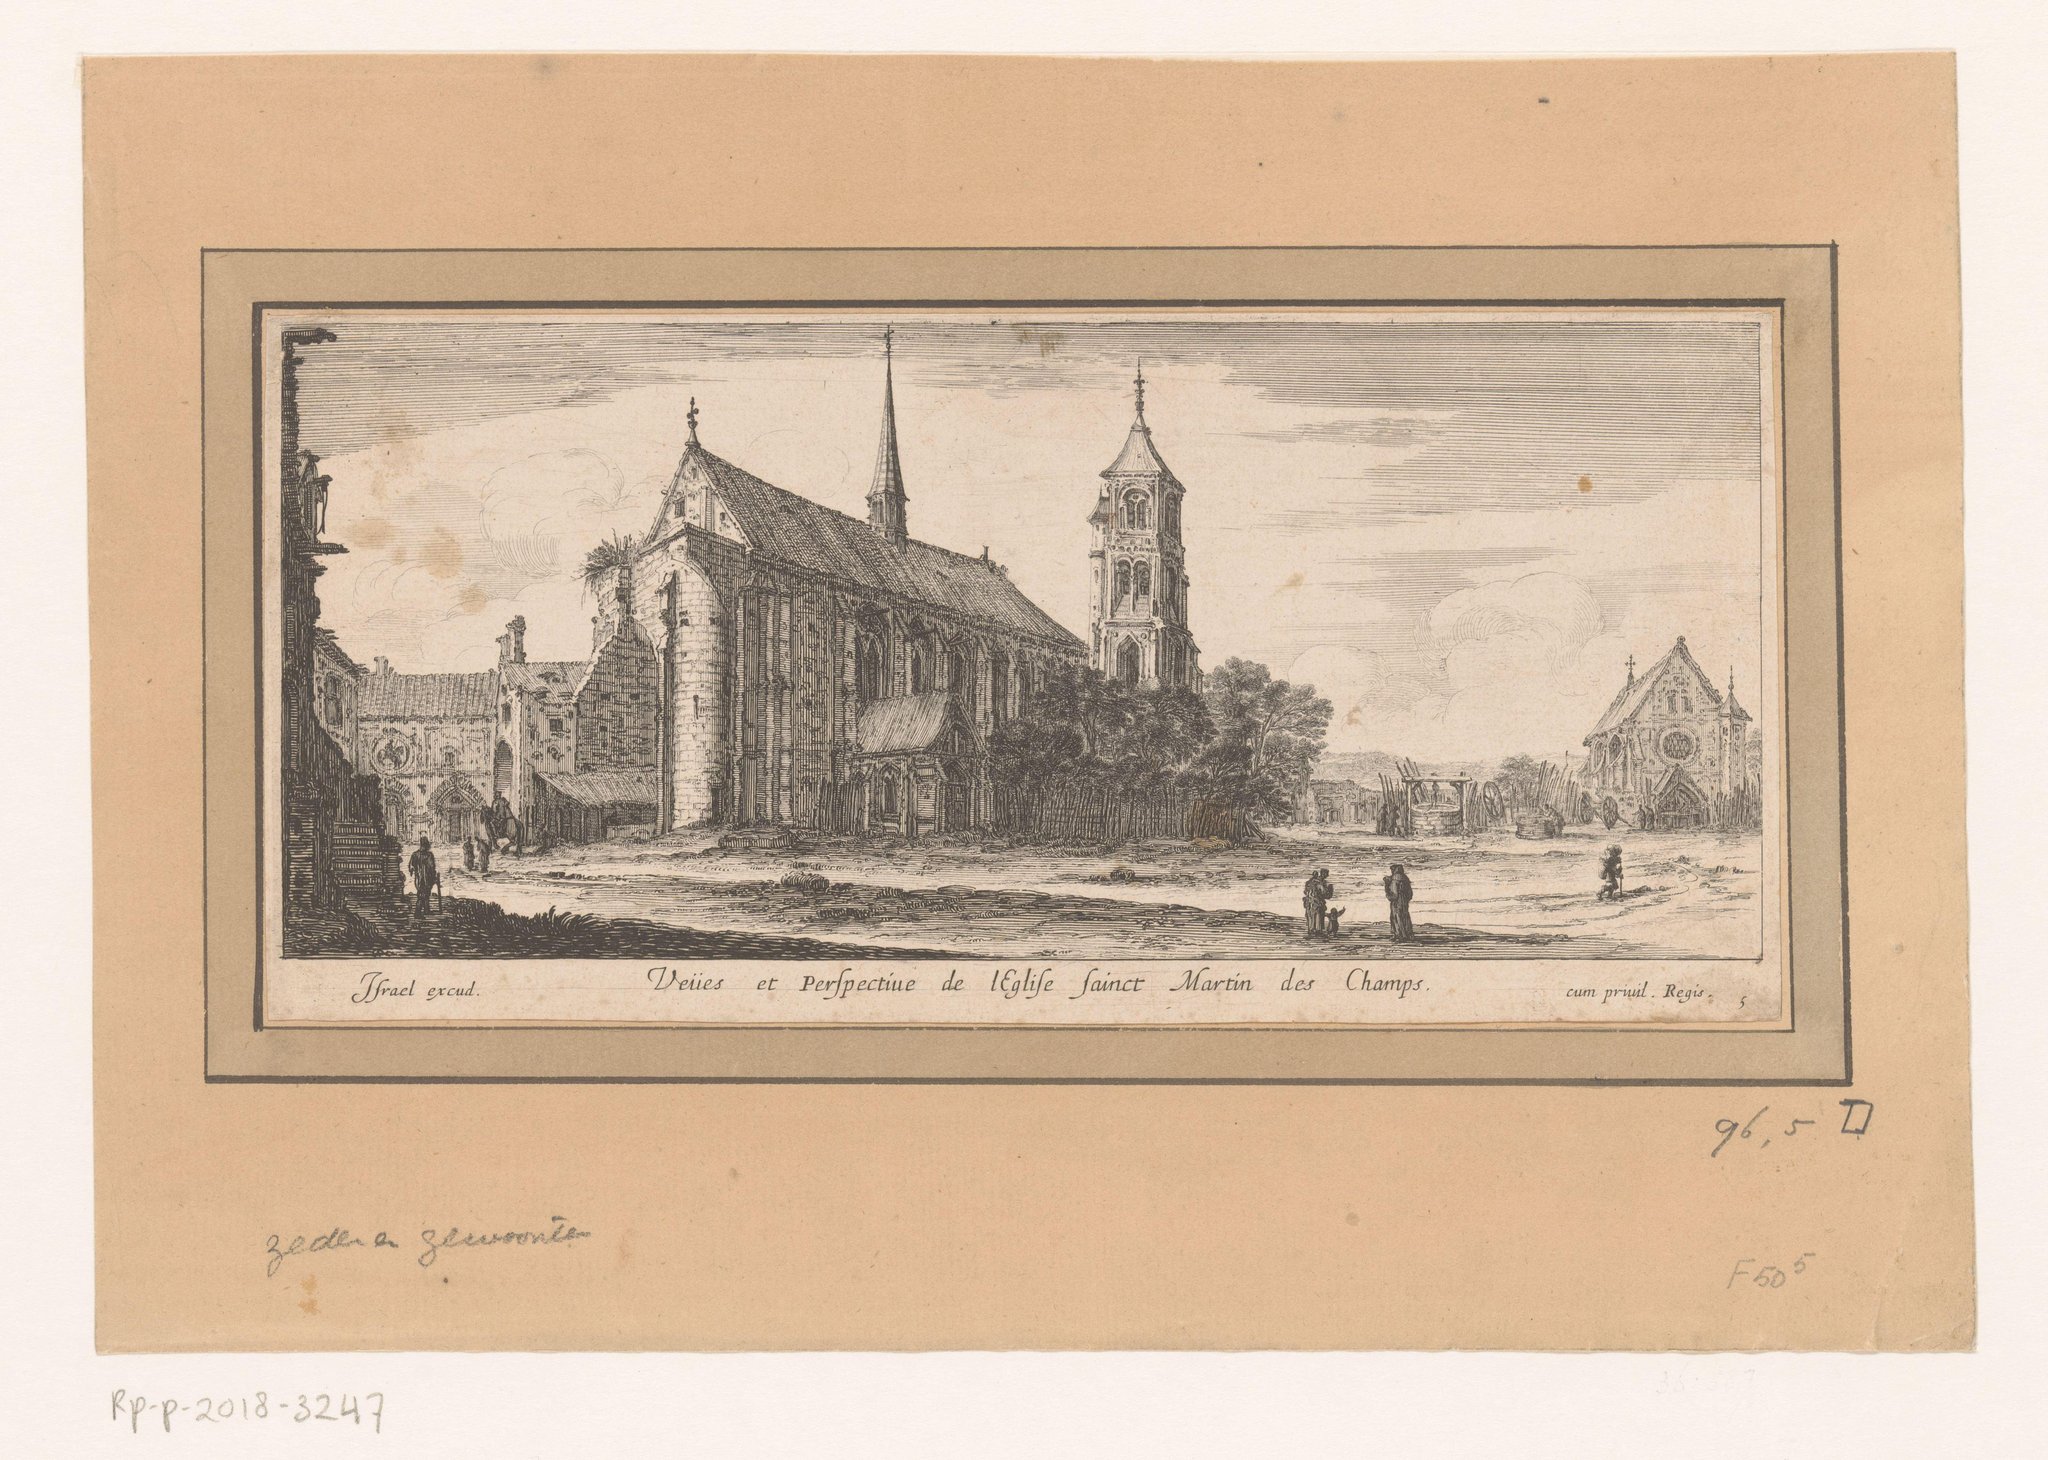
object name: print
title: Gezicht op de Église Saint-Martin-des-Champs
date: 1643-1661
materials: paper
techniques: etching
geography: paris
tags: city-view, and landscape with man-made constructions, roman catholic church, paris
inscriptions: collector's mark: Lugt 2228